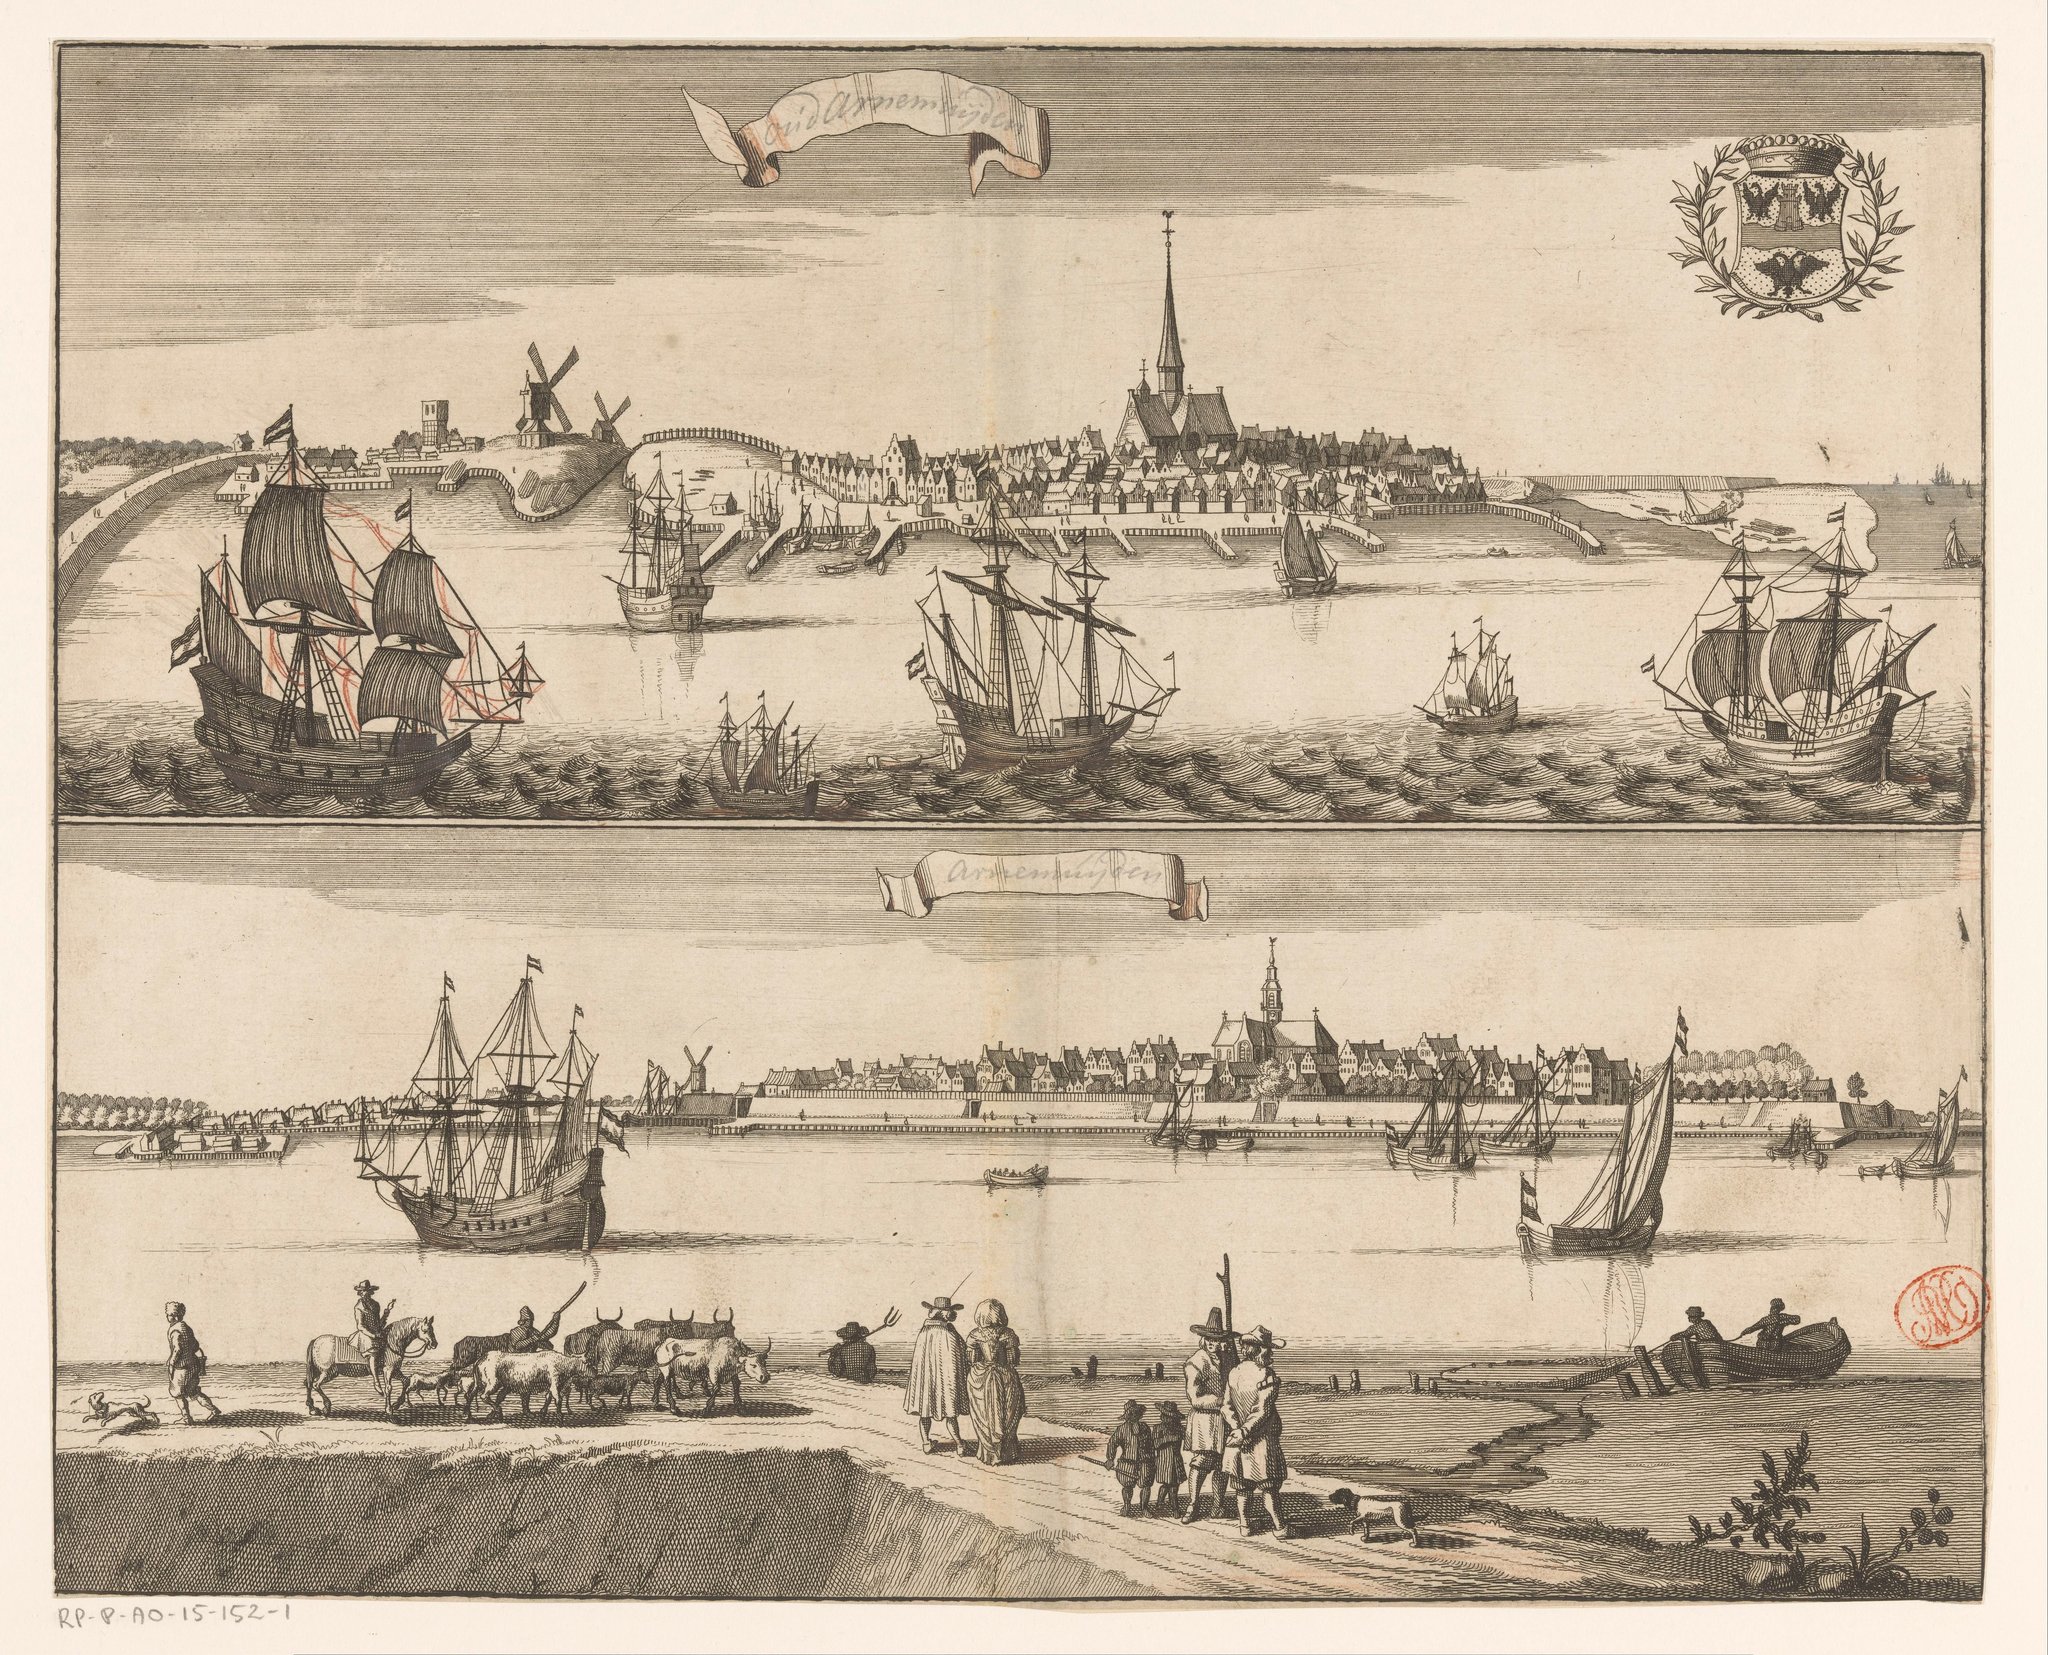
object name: print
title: Gezicht op Oud-Arnemuiden en gezicht op Arnemuiden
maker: Anonymous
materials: chalk, paper, pencil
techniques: etching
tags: coat of arms (as symbol of the state, etc.) (+ city; municipal), church (exterior), prospect of city, town panorama, silhouette of city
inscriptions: inscription: ‘Oud Arnemuijden’, inscription: ‘Arnemuijden’, collector's mark: Lugt 195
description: Tweede bekende staat van prent (rechtsboven genummerd) ook gebruikt in: Smallegange, Mattheus. Nieuwe Cronyk van Zeeland (…). Middelburg en Amsterdam: Johannes Meertens en Abraham van Someren, 1696. Derde bekende staat van prent (geen nummering rechtsboven) ook gebruikt in: Heussen, Hugo Franciscus van. Oudheden en gestichten van Zeeland (…). 2 delen. Leiden: Christiaan Vermey, 1722, dl. 1. En in: Aa, Pieter van der. La galerie agreable du monde (...). 66 delen. Leiden: Pieter van der Aa, 1728, dl. 21. Zie ook RP-P-AO-15-152-2 en RP-P-AO-15-152-3.